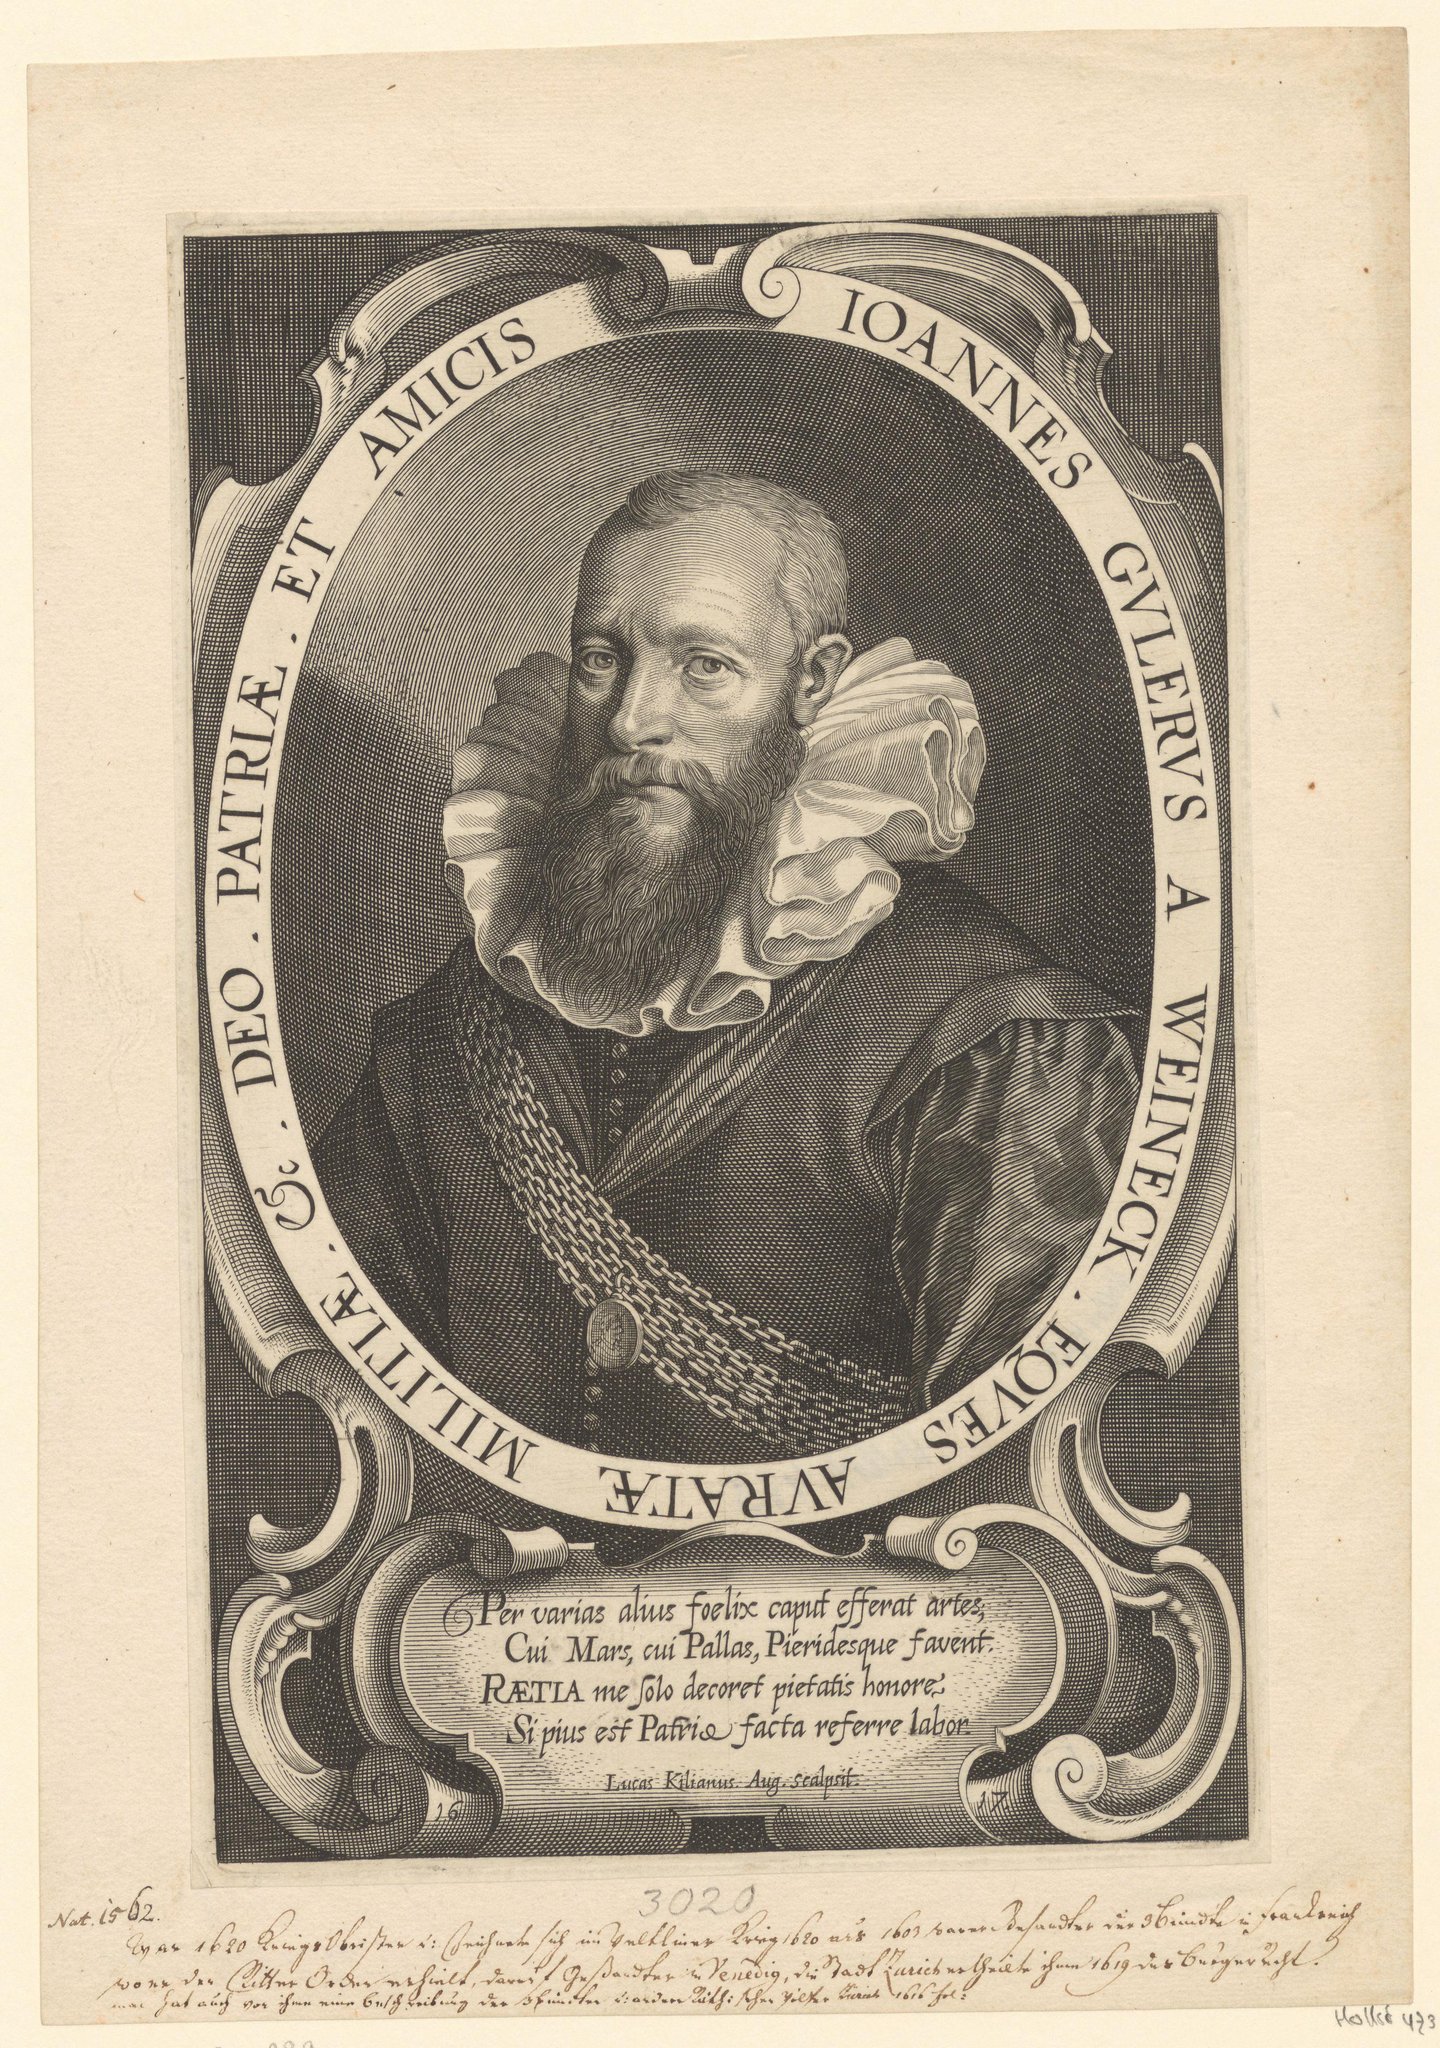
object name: print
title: Portret van Johannes Guler von Wyneck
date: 1617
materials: paper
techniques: engraving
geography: augsburg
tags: switzerland, historical persons, officer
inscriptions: collector's mark: Lugt 2228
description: Tekst in het Latijn in de omlijsting en in de cartouche.